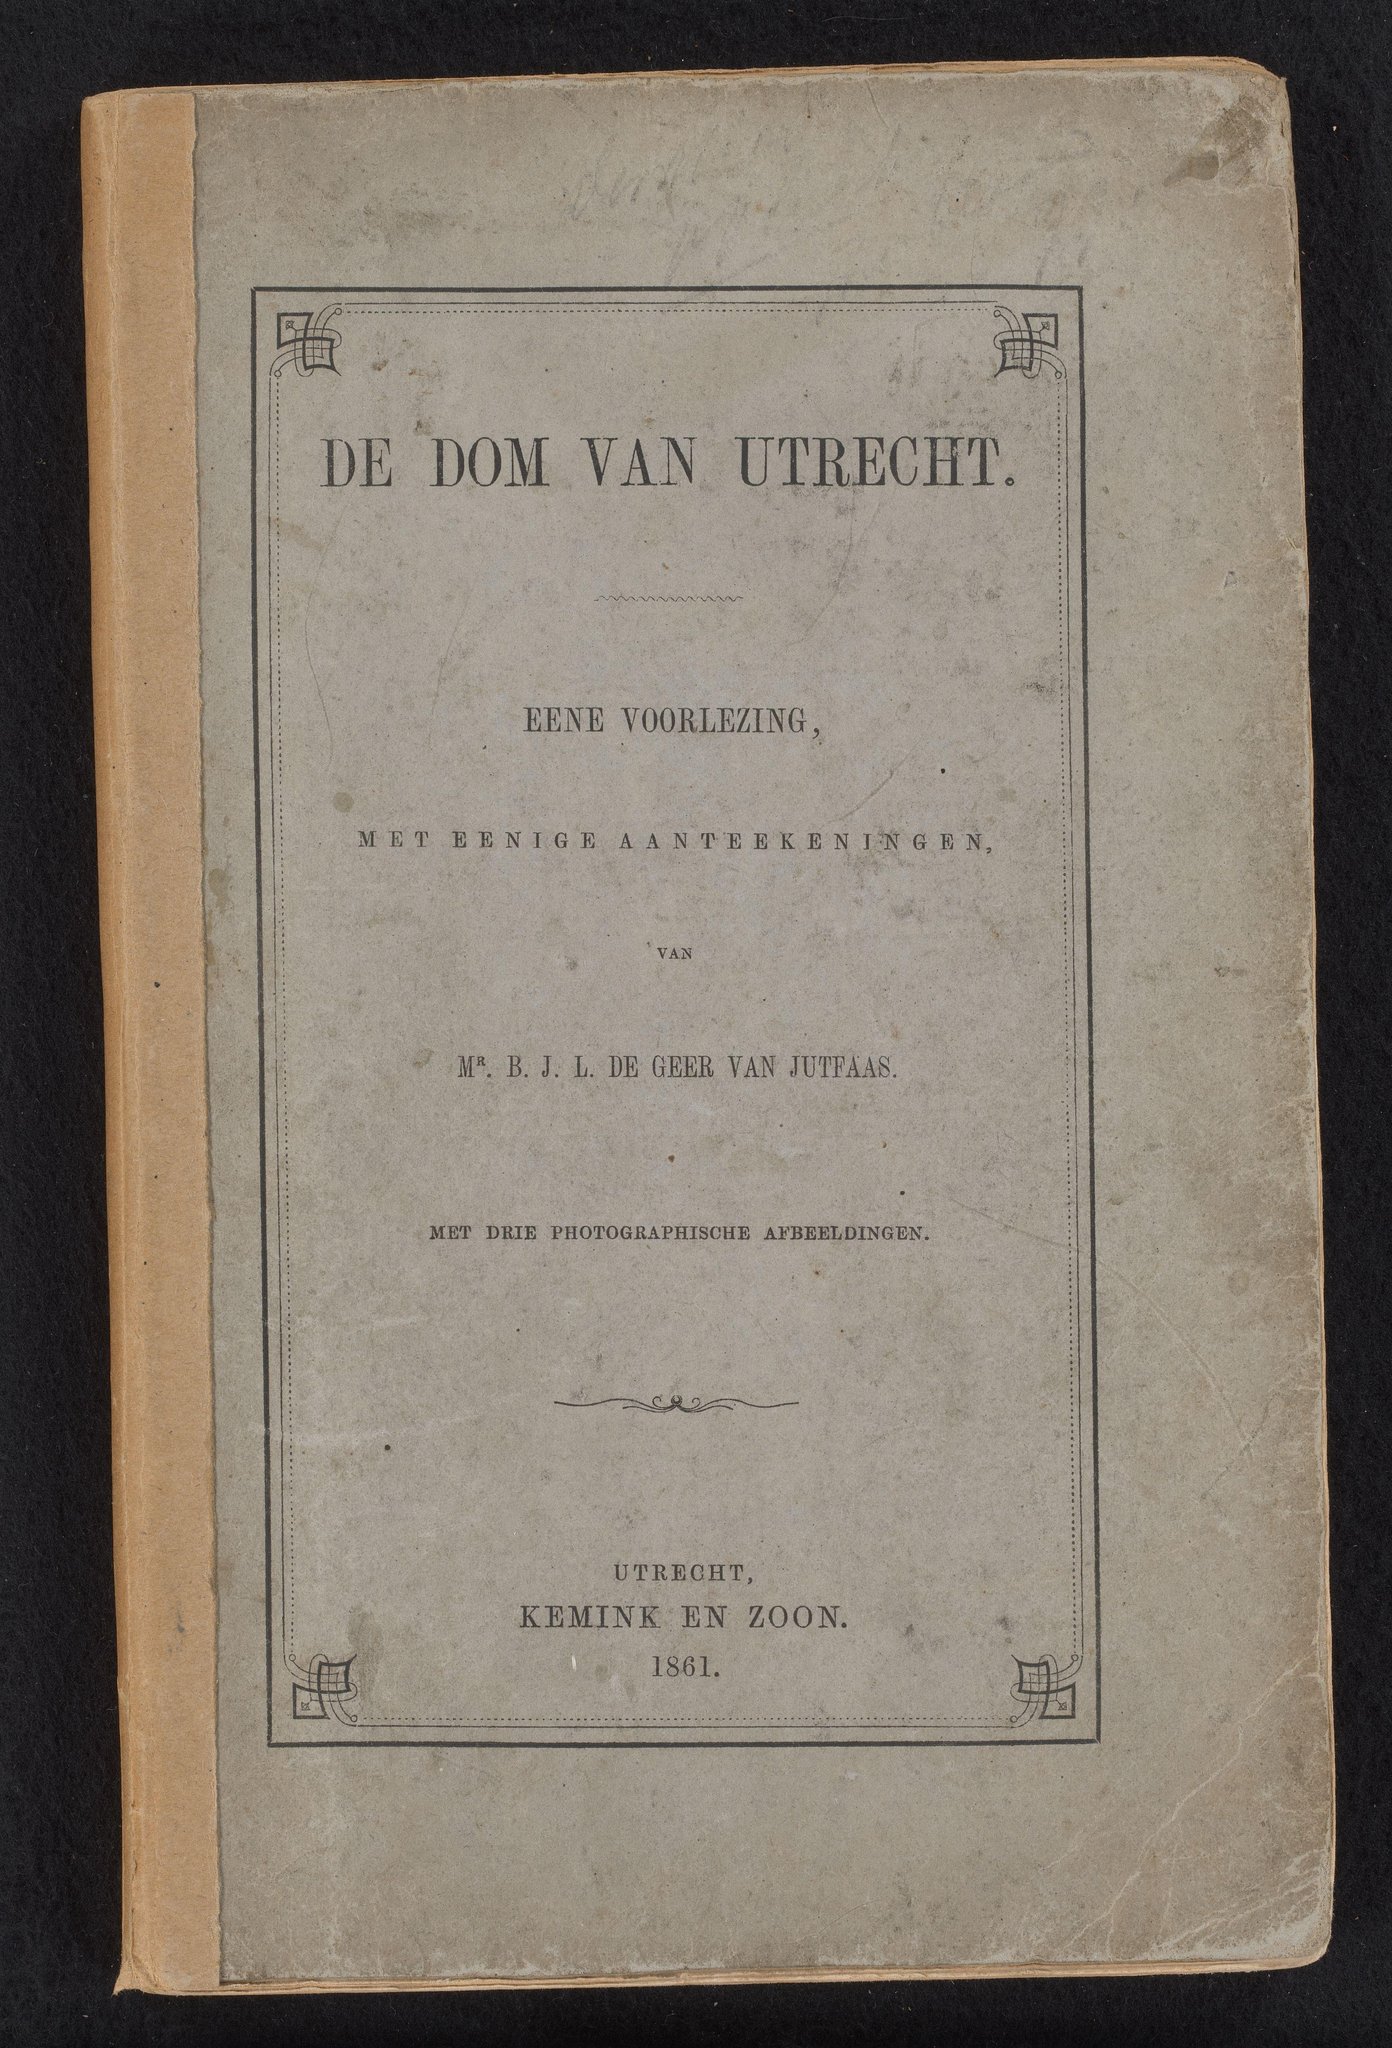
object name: book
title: De Dom van Utrecht : eene voorlezing, met eenige aanteekeningen [met drie photographische afbeeldingen]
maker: barthold jacob lintelo de geer van jutphaas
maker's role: hoogleraar, jurist, rector, schrijver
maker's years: 1816-1903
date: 1861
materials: cardboard, paper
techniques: albumen print, letterpress printing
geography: utrecht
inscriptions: collector's mark: ‘BIBLIOTHEEK/ RIJKSMUSEUM/ AMSTERDAM’, inscription: ‘30,-’